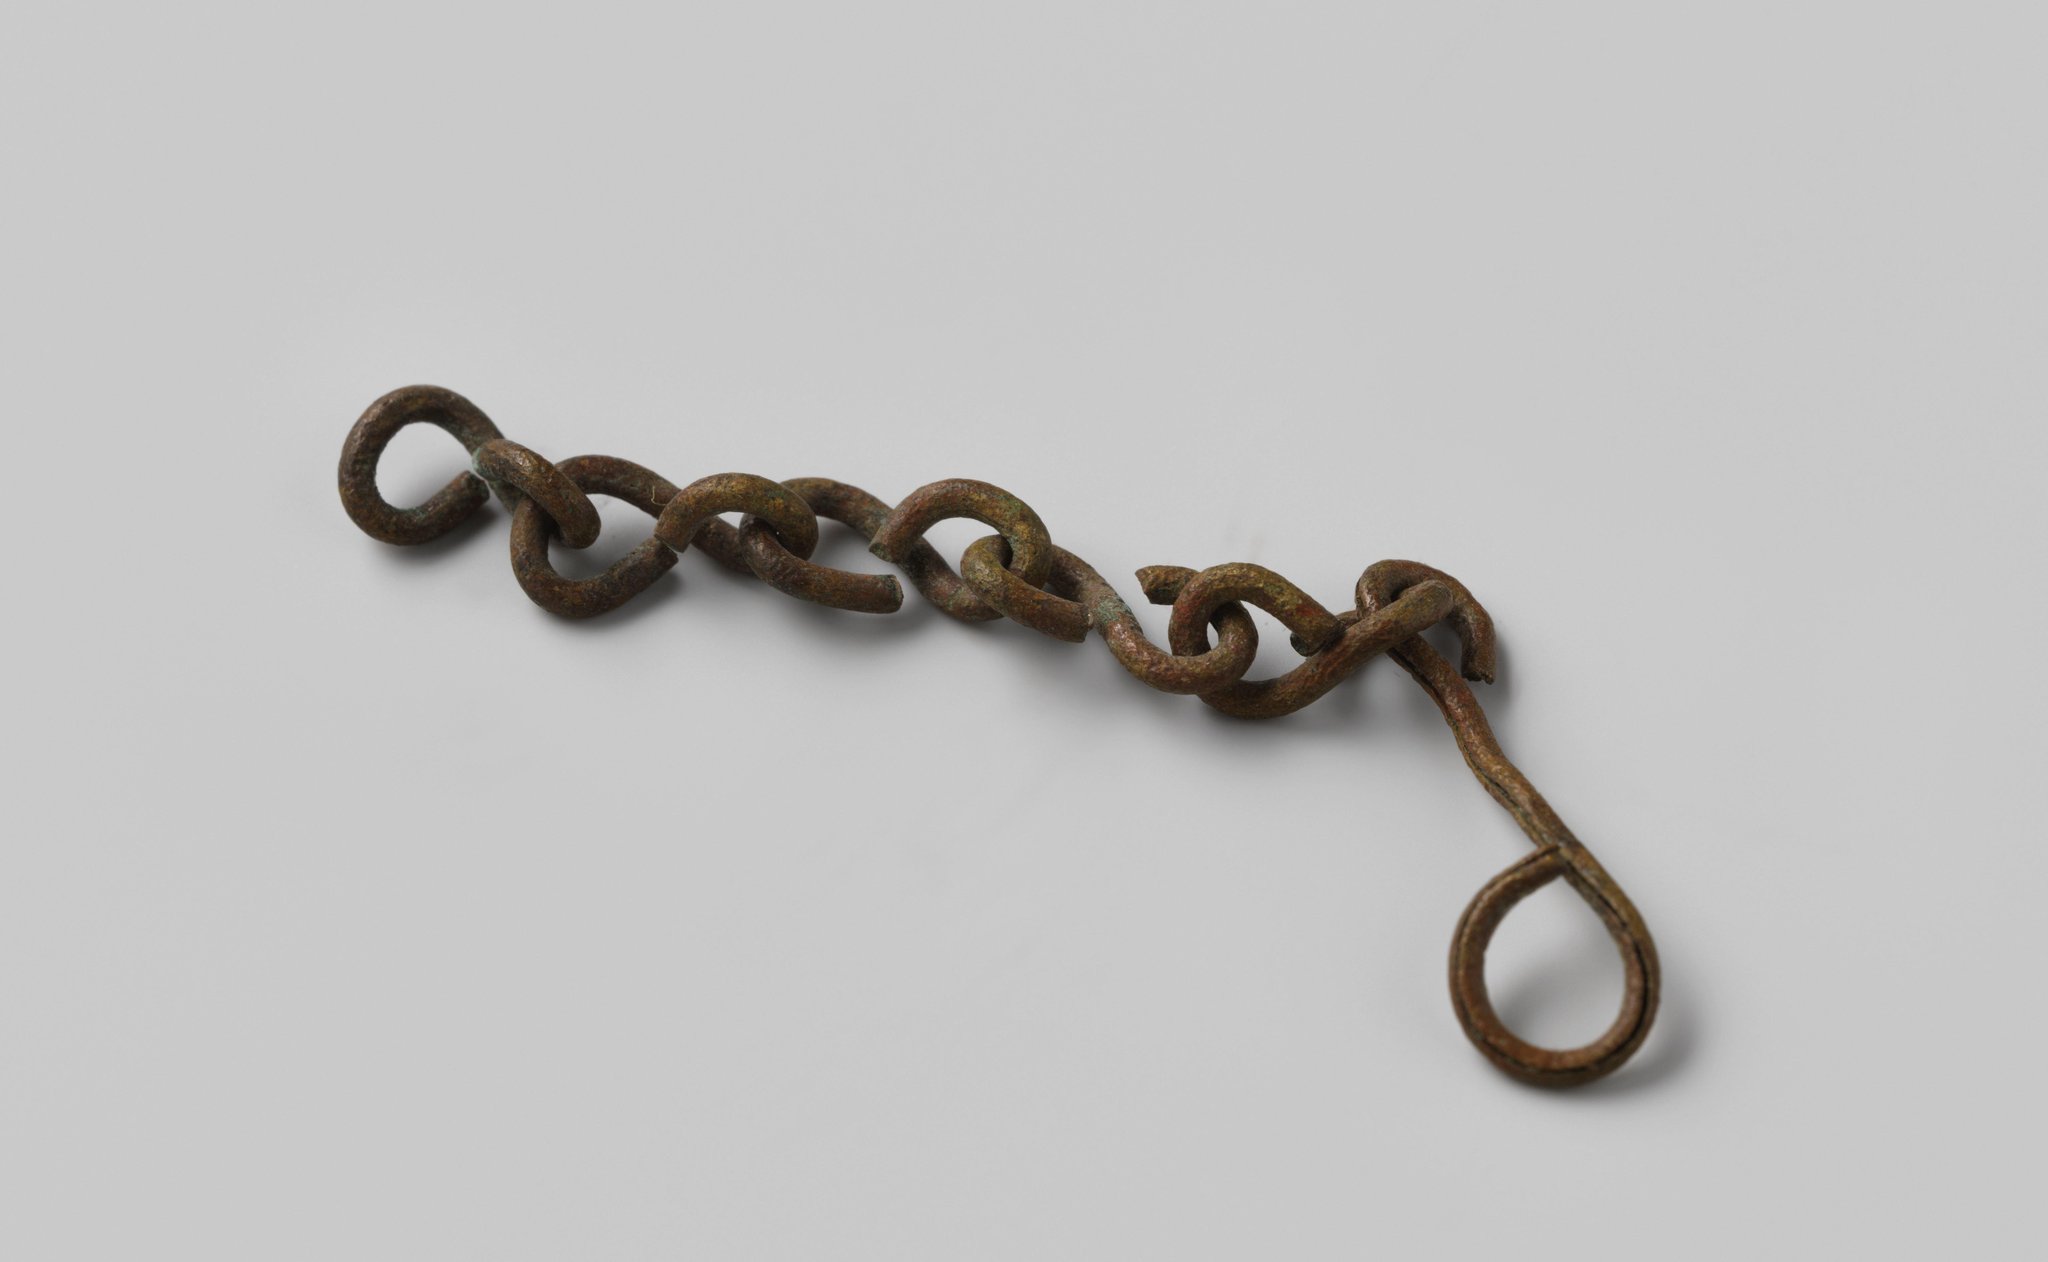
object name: fragment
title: Fragment van een ketting uit het wrak van de Oost-Indiëvaarder Hollandia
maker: Anonymous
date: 1700-1743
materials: copper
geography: netherlands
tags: verenigde oostindische compagnie, hollandia (schip), annet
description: Varied parts or fragments, chains; 6 fragm: links, of wire, figure-of-eight-shaped, twisted, with a horizontal and a vertical loop: link, of wire, oblong with circular loop on each end.